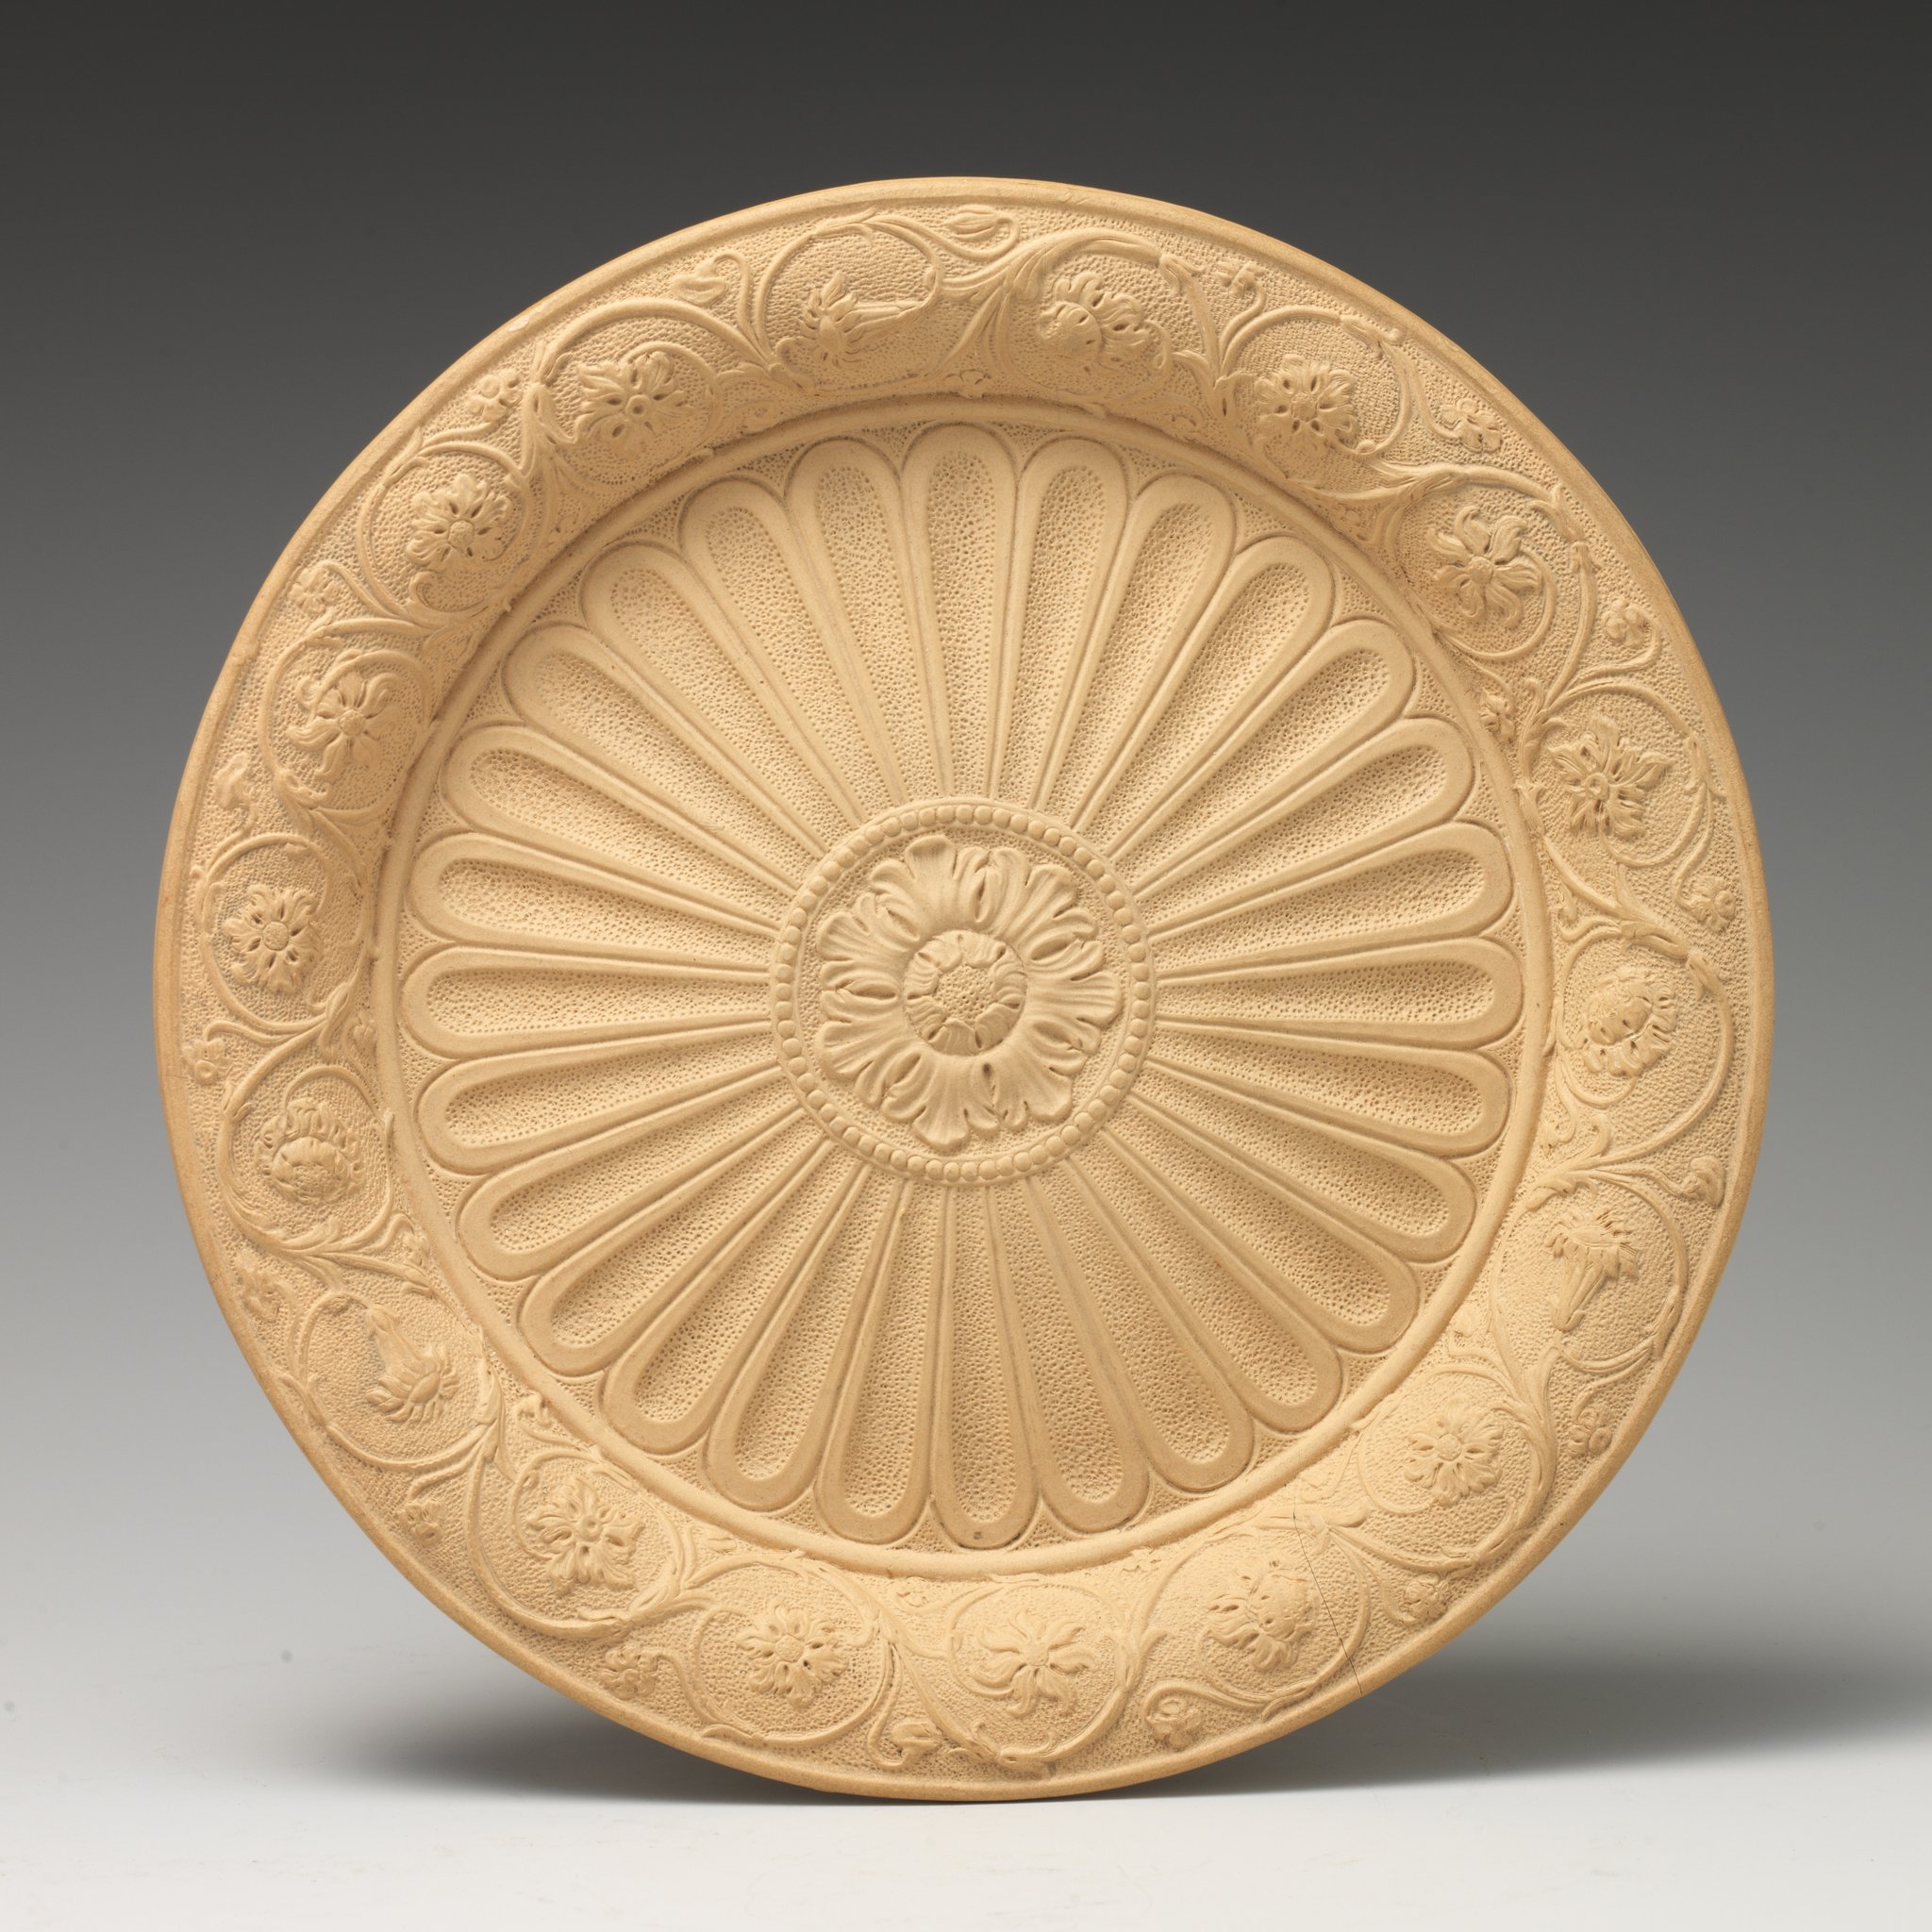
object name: dish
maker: longton hall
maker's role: factory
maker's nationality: british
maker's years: 1744-1760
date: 1800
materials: stoneware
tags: flowers